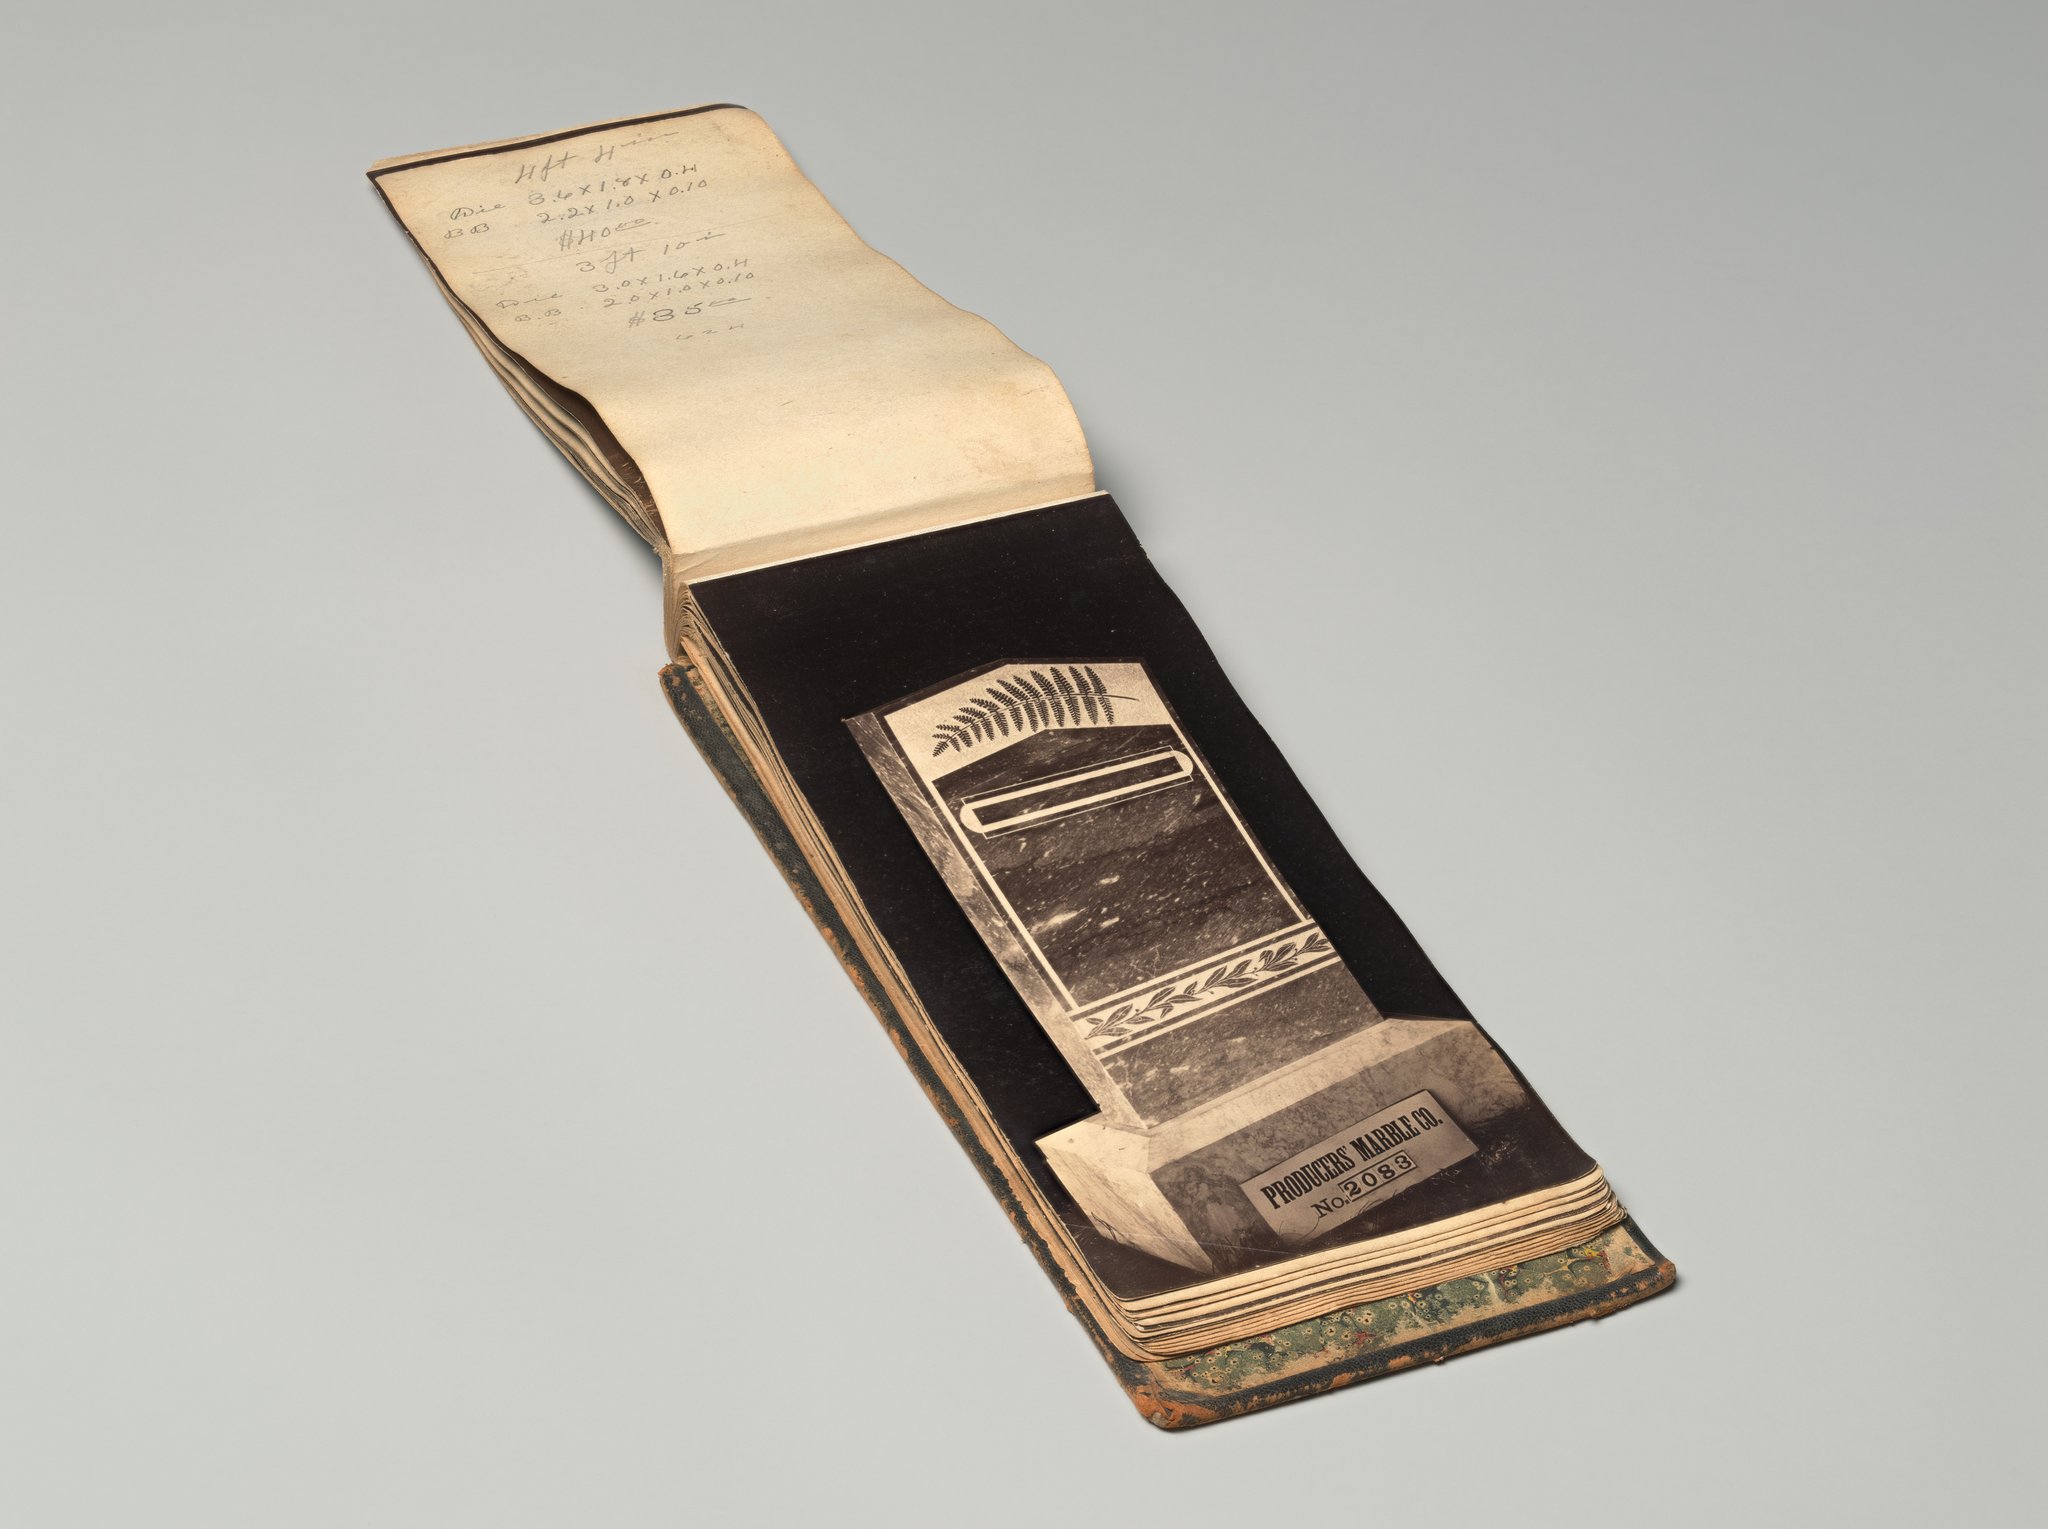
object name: album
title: [Vermont Marble Tombstone Catalogue]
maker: Anonymous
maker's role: artist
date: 1880-1889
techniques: albumen silver print